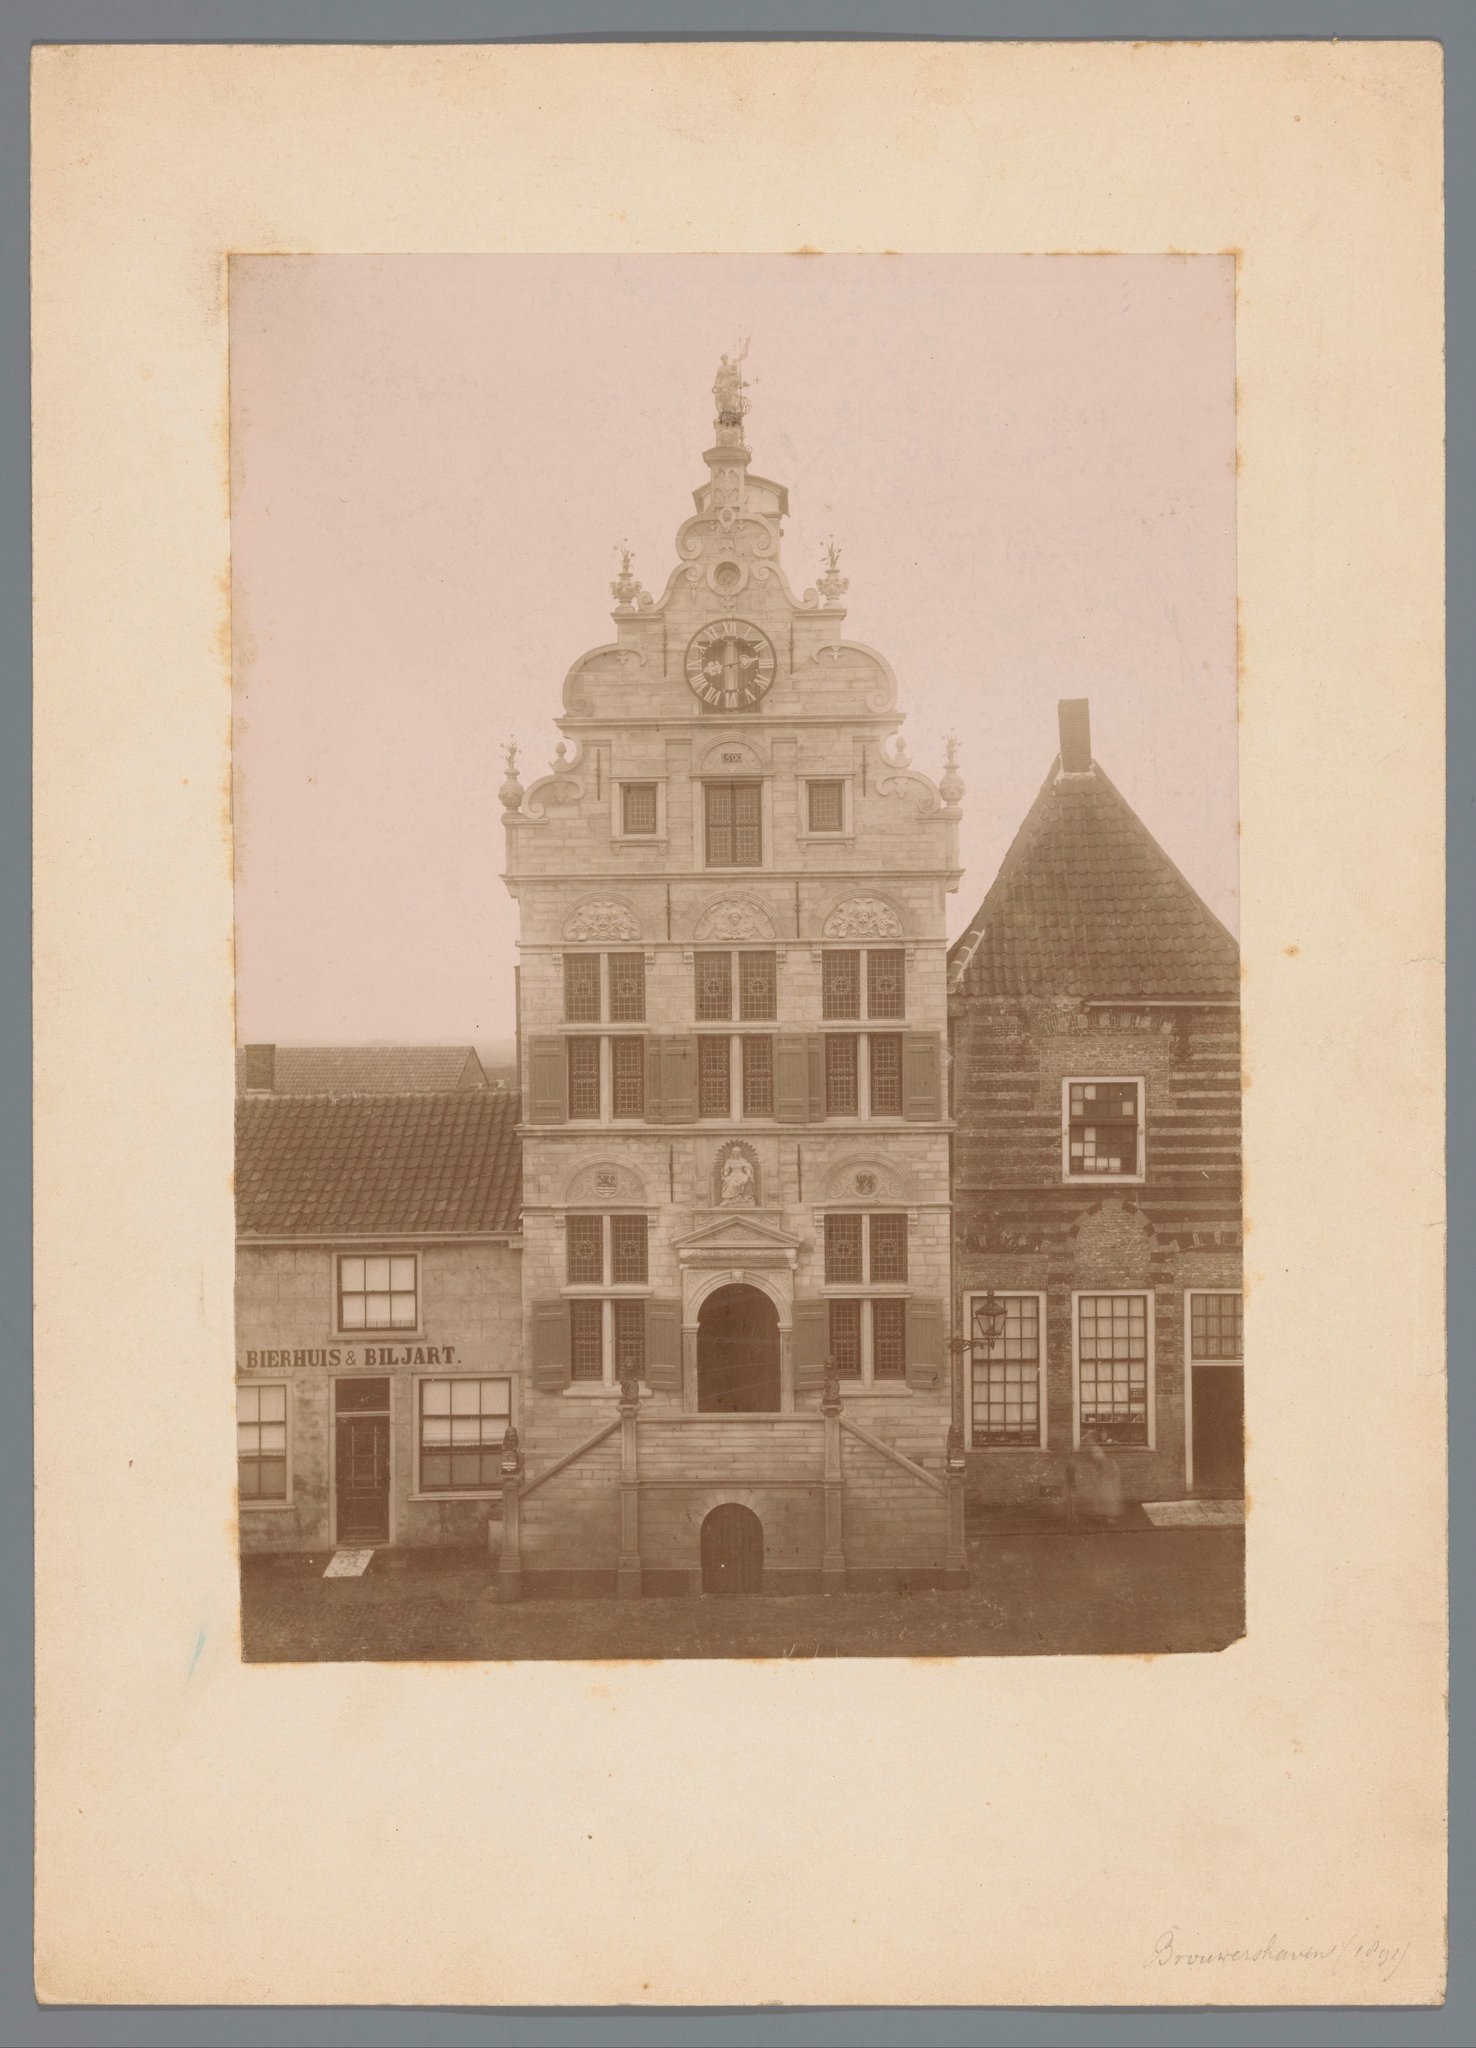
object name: photograph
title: Voorgevel van het stadhuis van Brouwershaven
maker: adriaan bos jr.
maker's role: fotograaf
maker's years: 1869-1940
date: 1891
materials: cardboard, photographic support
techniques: collodion silver print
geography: brouwershaven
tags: townhall, façade (of house or building)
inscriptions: name: ‘A. Bos Jr. Photograaf’, name: ‘S. Franco, b.i. den Haag.’, inscription: ‘Brouwershaven (1891)’